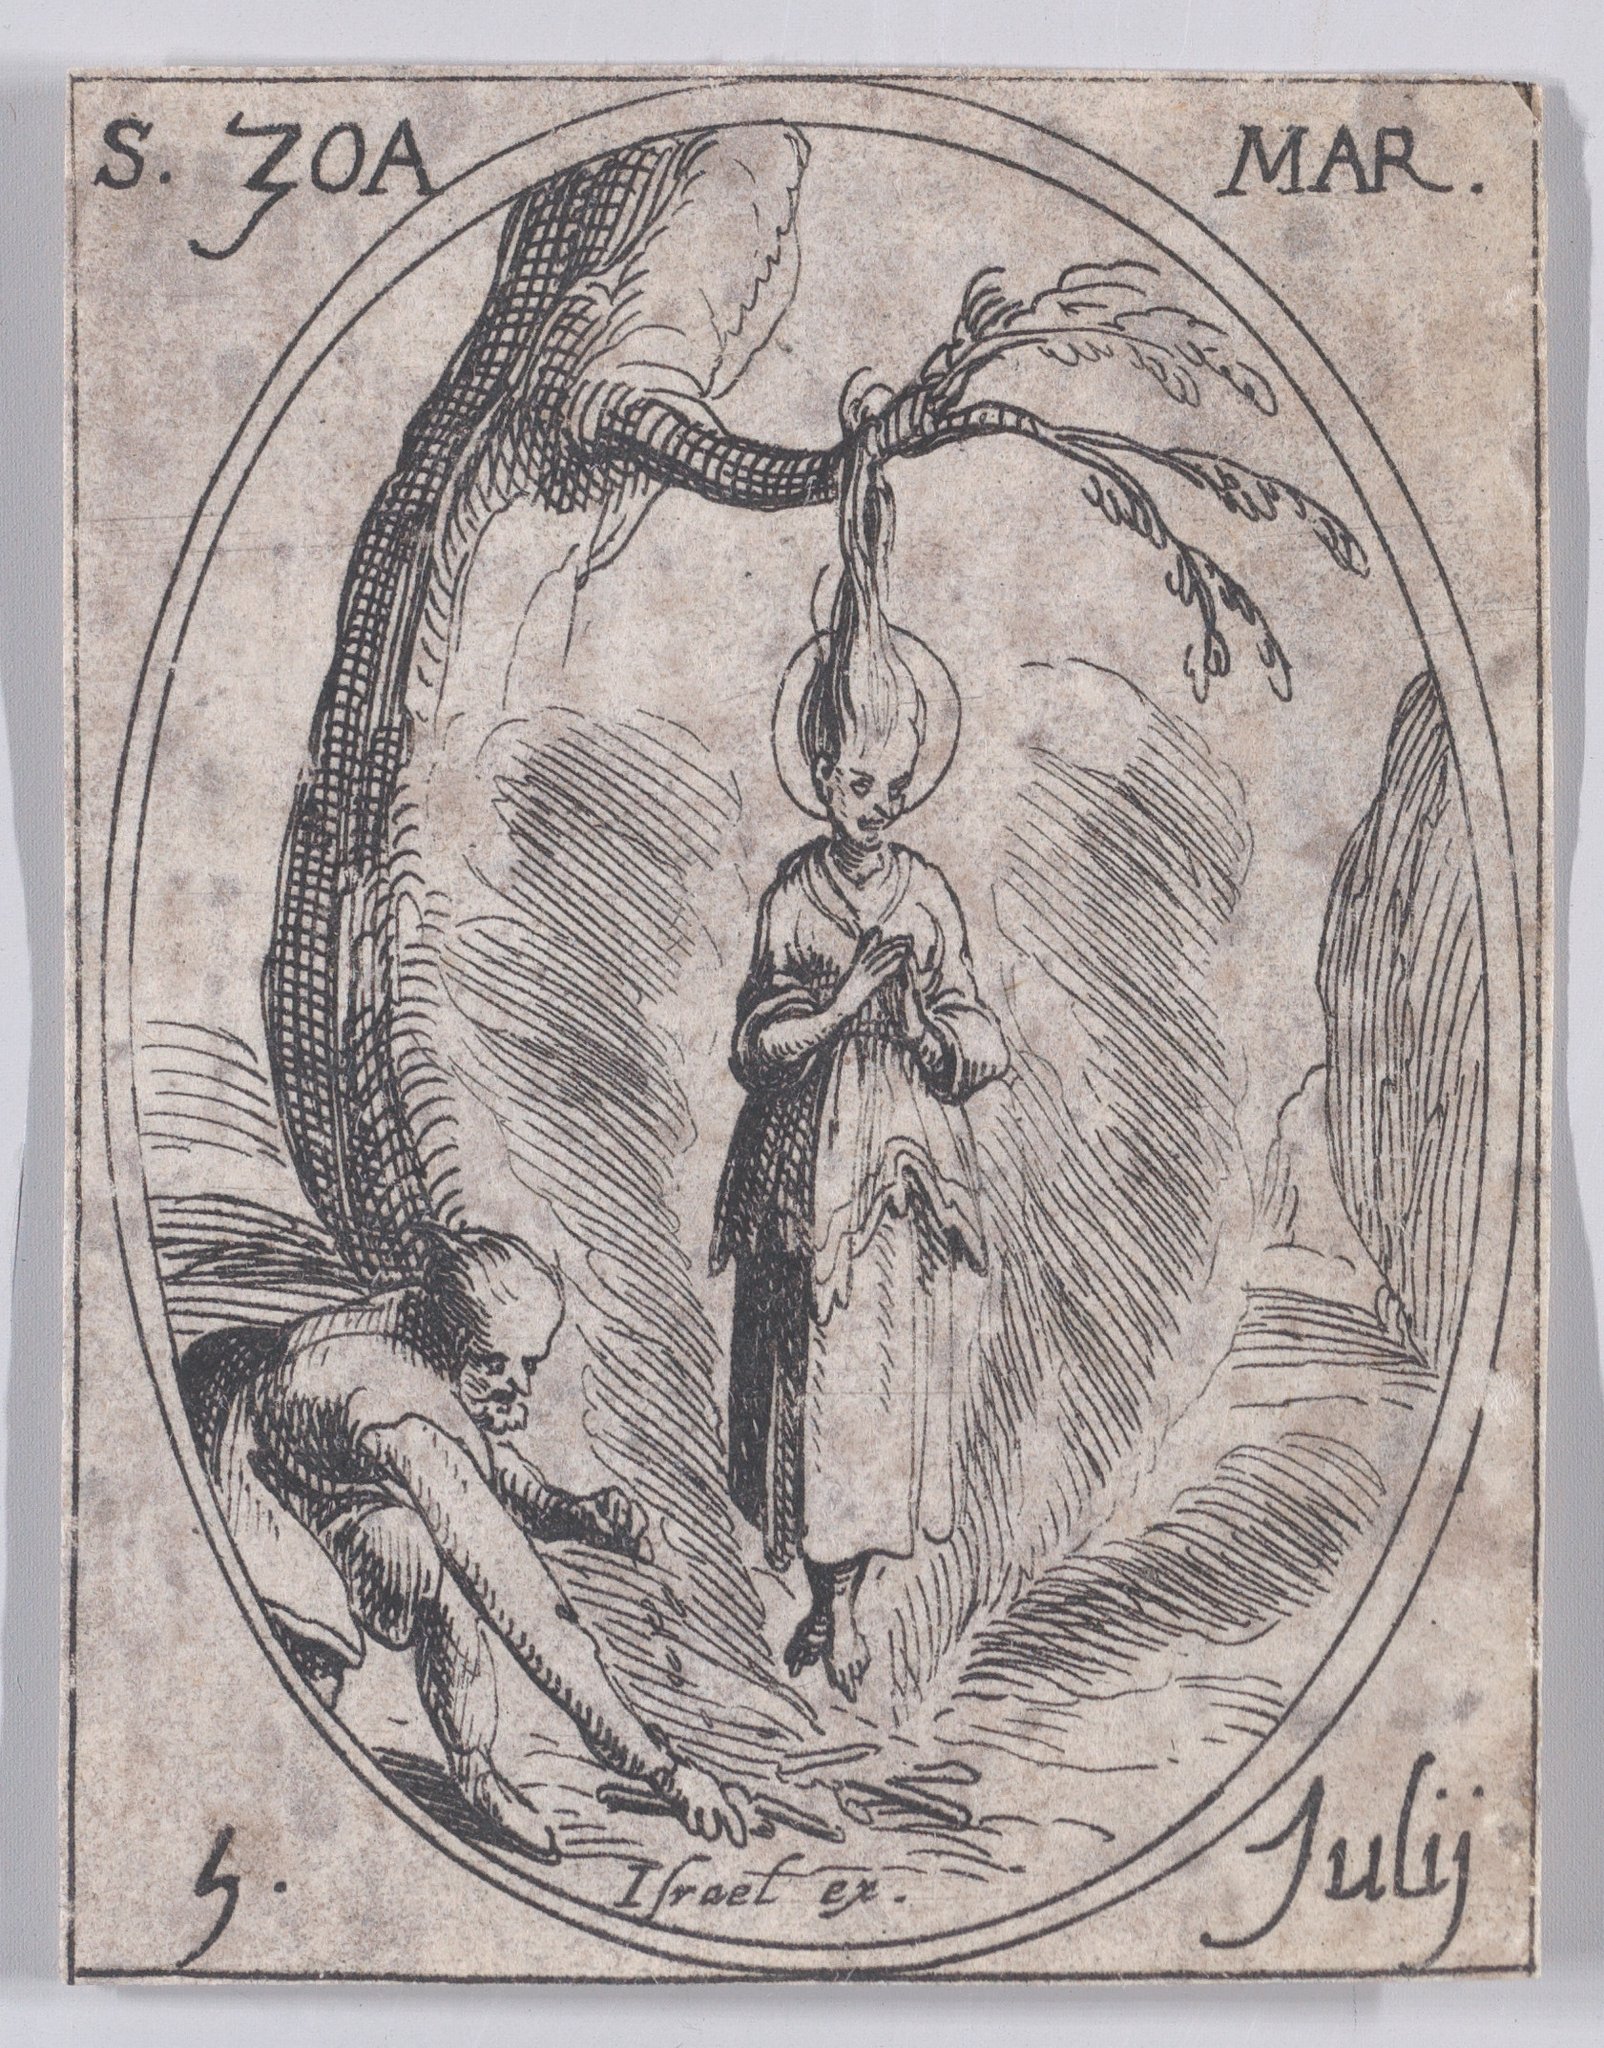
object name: print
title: Ste. Zoé, martyre (St. Zoe, Martyr), July 5th, from "Les Images De Tous Les Saincts et Saintes de L'Année" (Images of All of the Saints and Religious Events of the Year)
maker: jacques callot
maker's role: artist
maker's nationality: french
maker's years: 1592-1635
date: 1636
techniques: etching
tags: men,women,saints